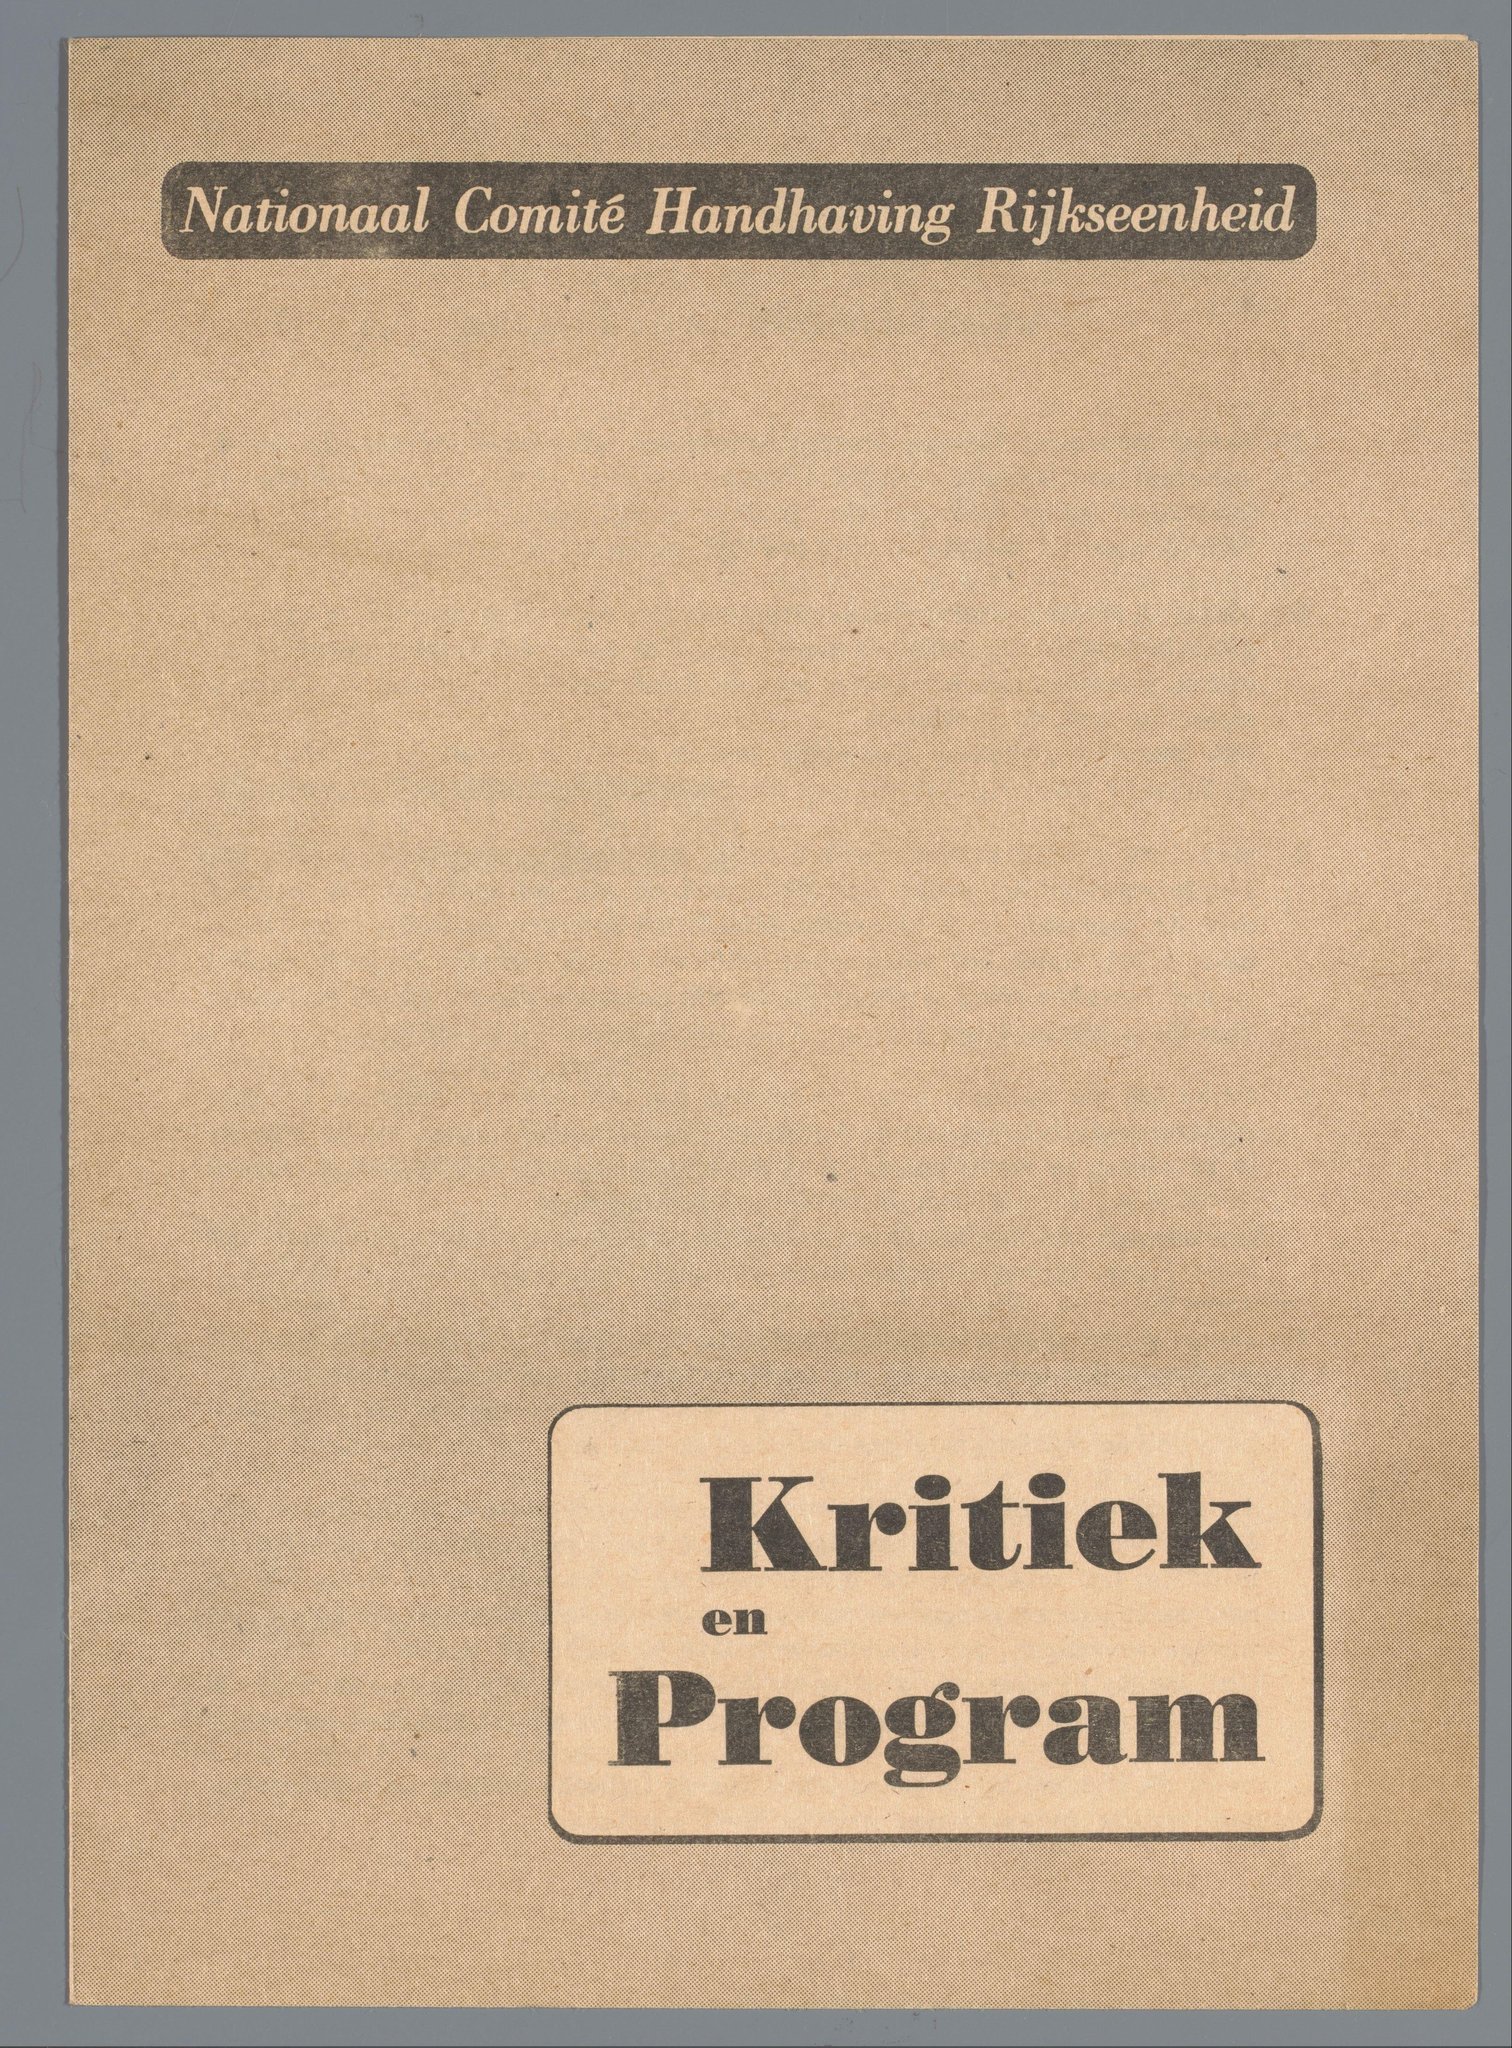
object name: folder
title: Kritiek en Program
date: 1947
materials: paper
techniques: printing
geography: the hague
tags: netherlands, indonesia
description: Folder van het nationaal Comite Rijkseenheid. Vouwblad, 4 pp met op de binnenzijde de tekst, verdeeld om kritiek (10 punten) en program (punten a t/m d).